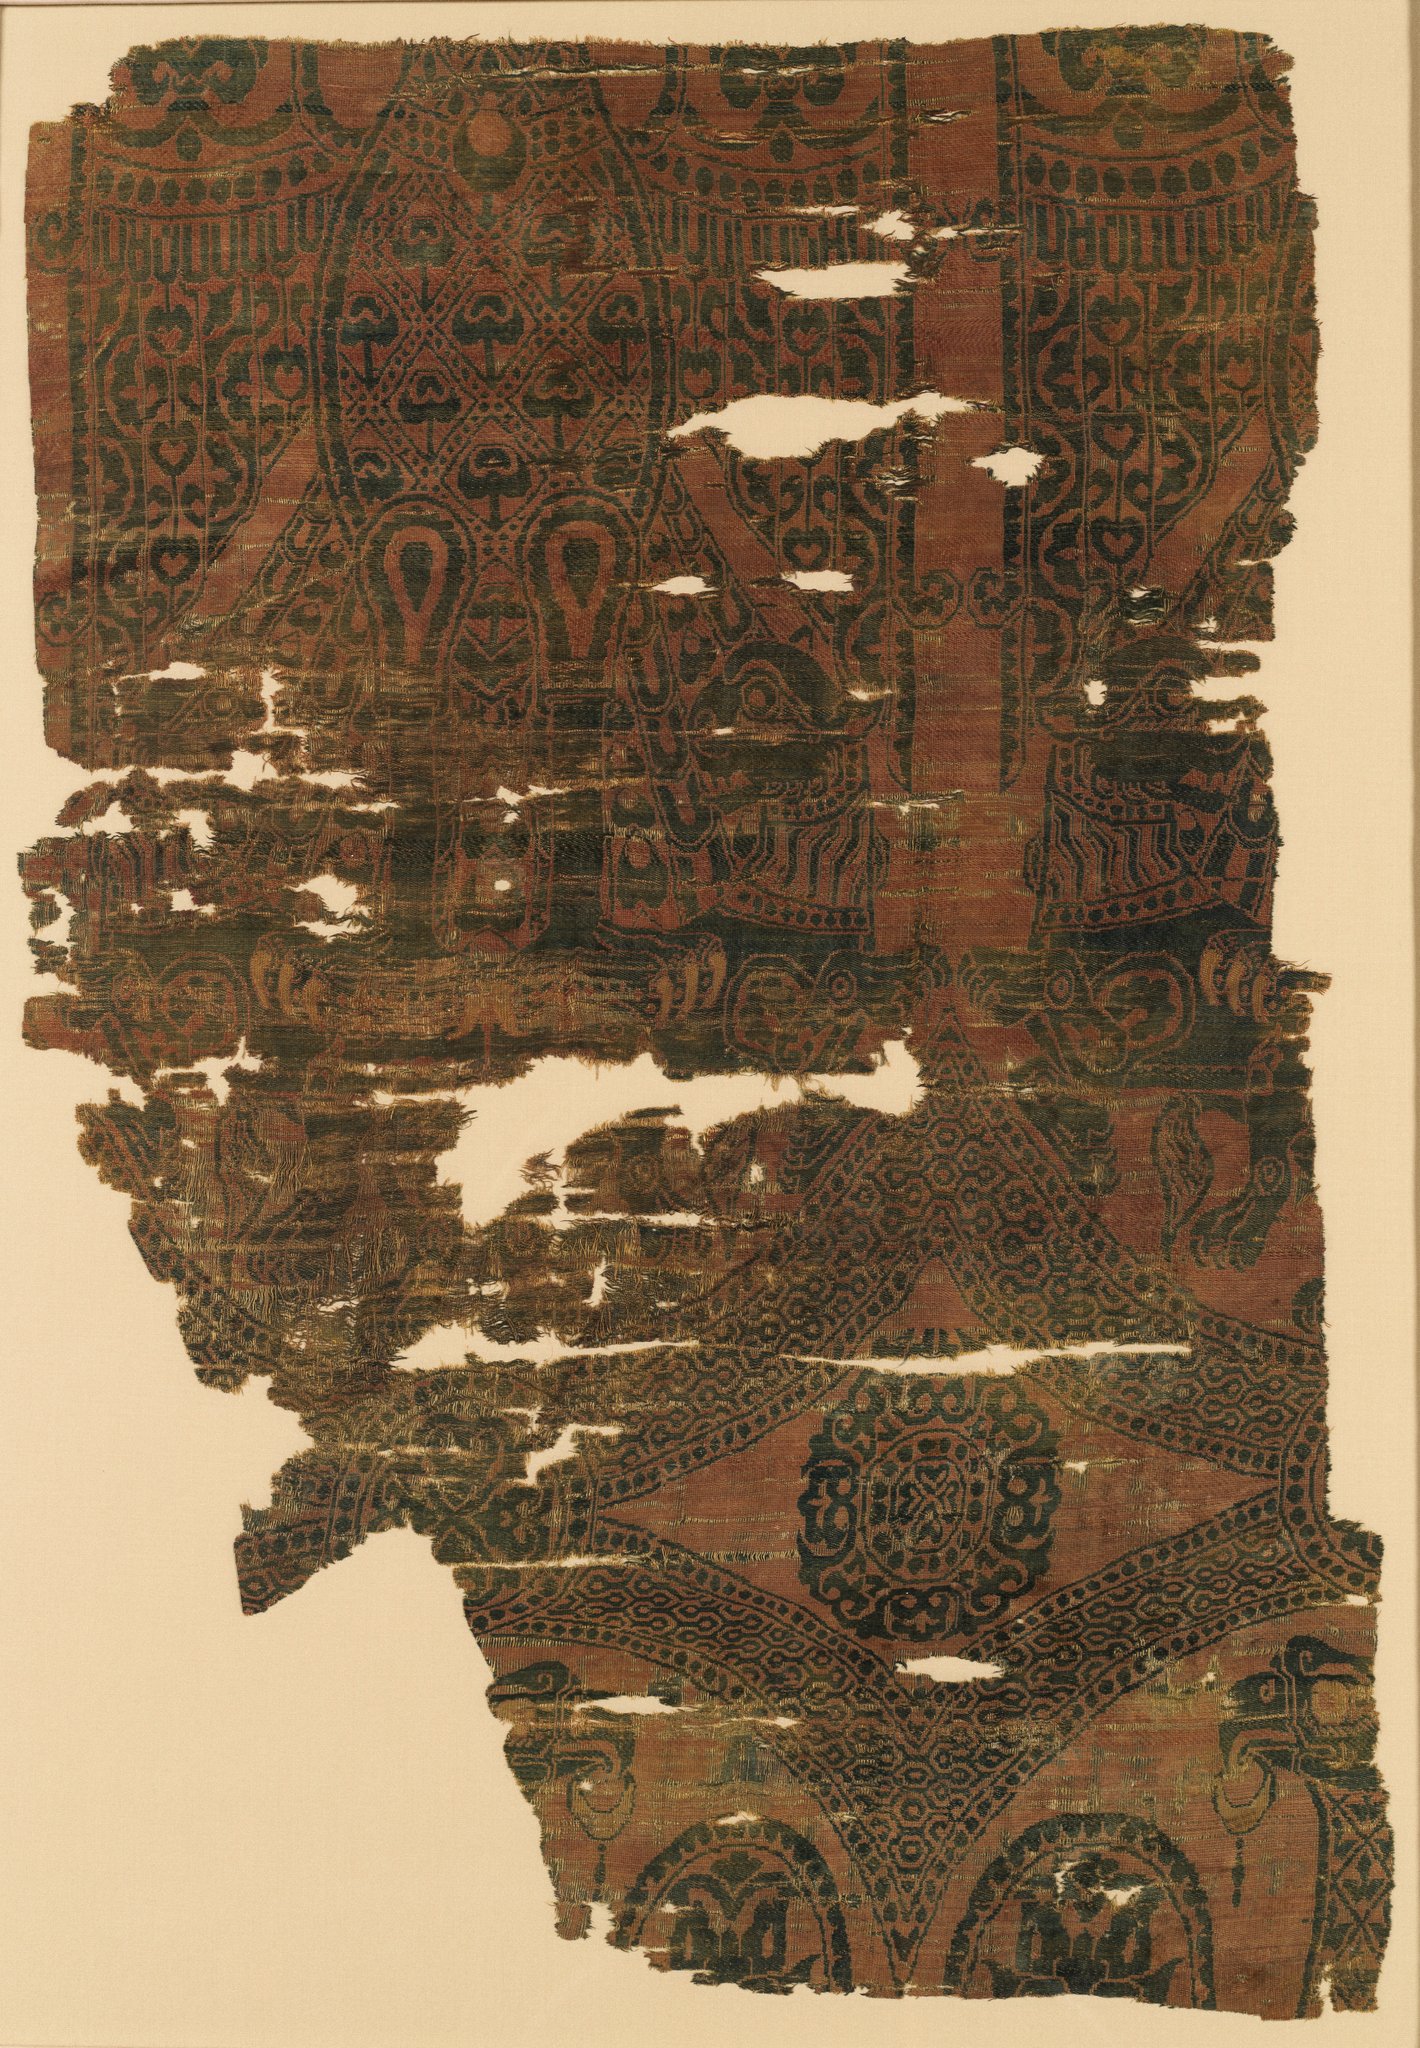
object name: textile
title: Textile Fragment with Double-Headed Eagles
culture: islamic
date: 1001-1200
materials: silk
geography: byzantium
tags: eagles